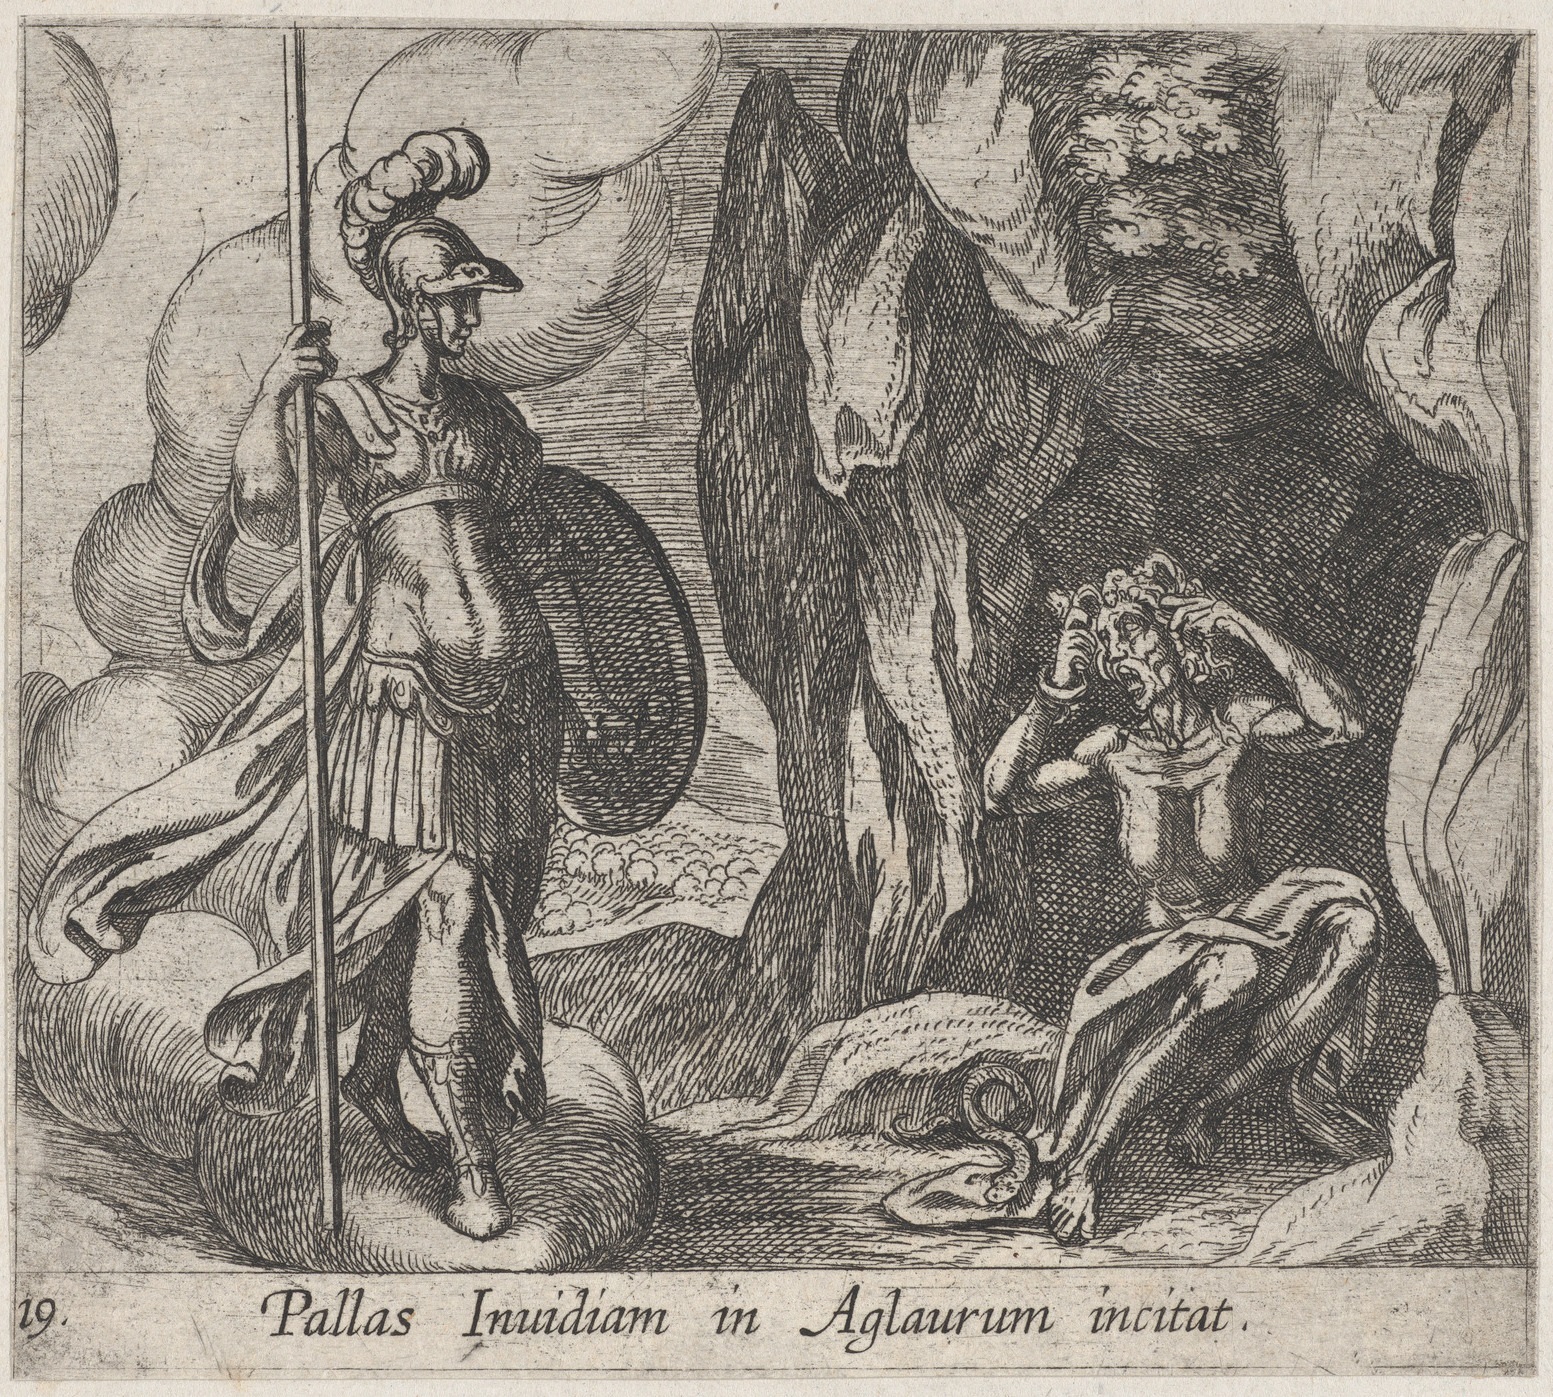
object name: print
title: Plate 19: Minerva at Envy's Cave (Pallas Invidiam in Aglaurum incitat), from Ovid's 'Metamorphoses'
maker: antonio tempesta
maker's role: artist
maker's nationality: italian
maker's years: 1555-1630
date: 1606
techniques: etching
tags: soldiers,weapons,minerva,caves